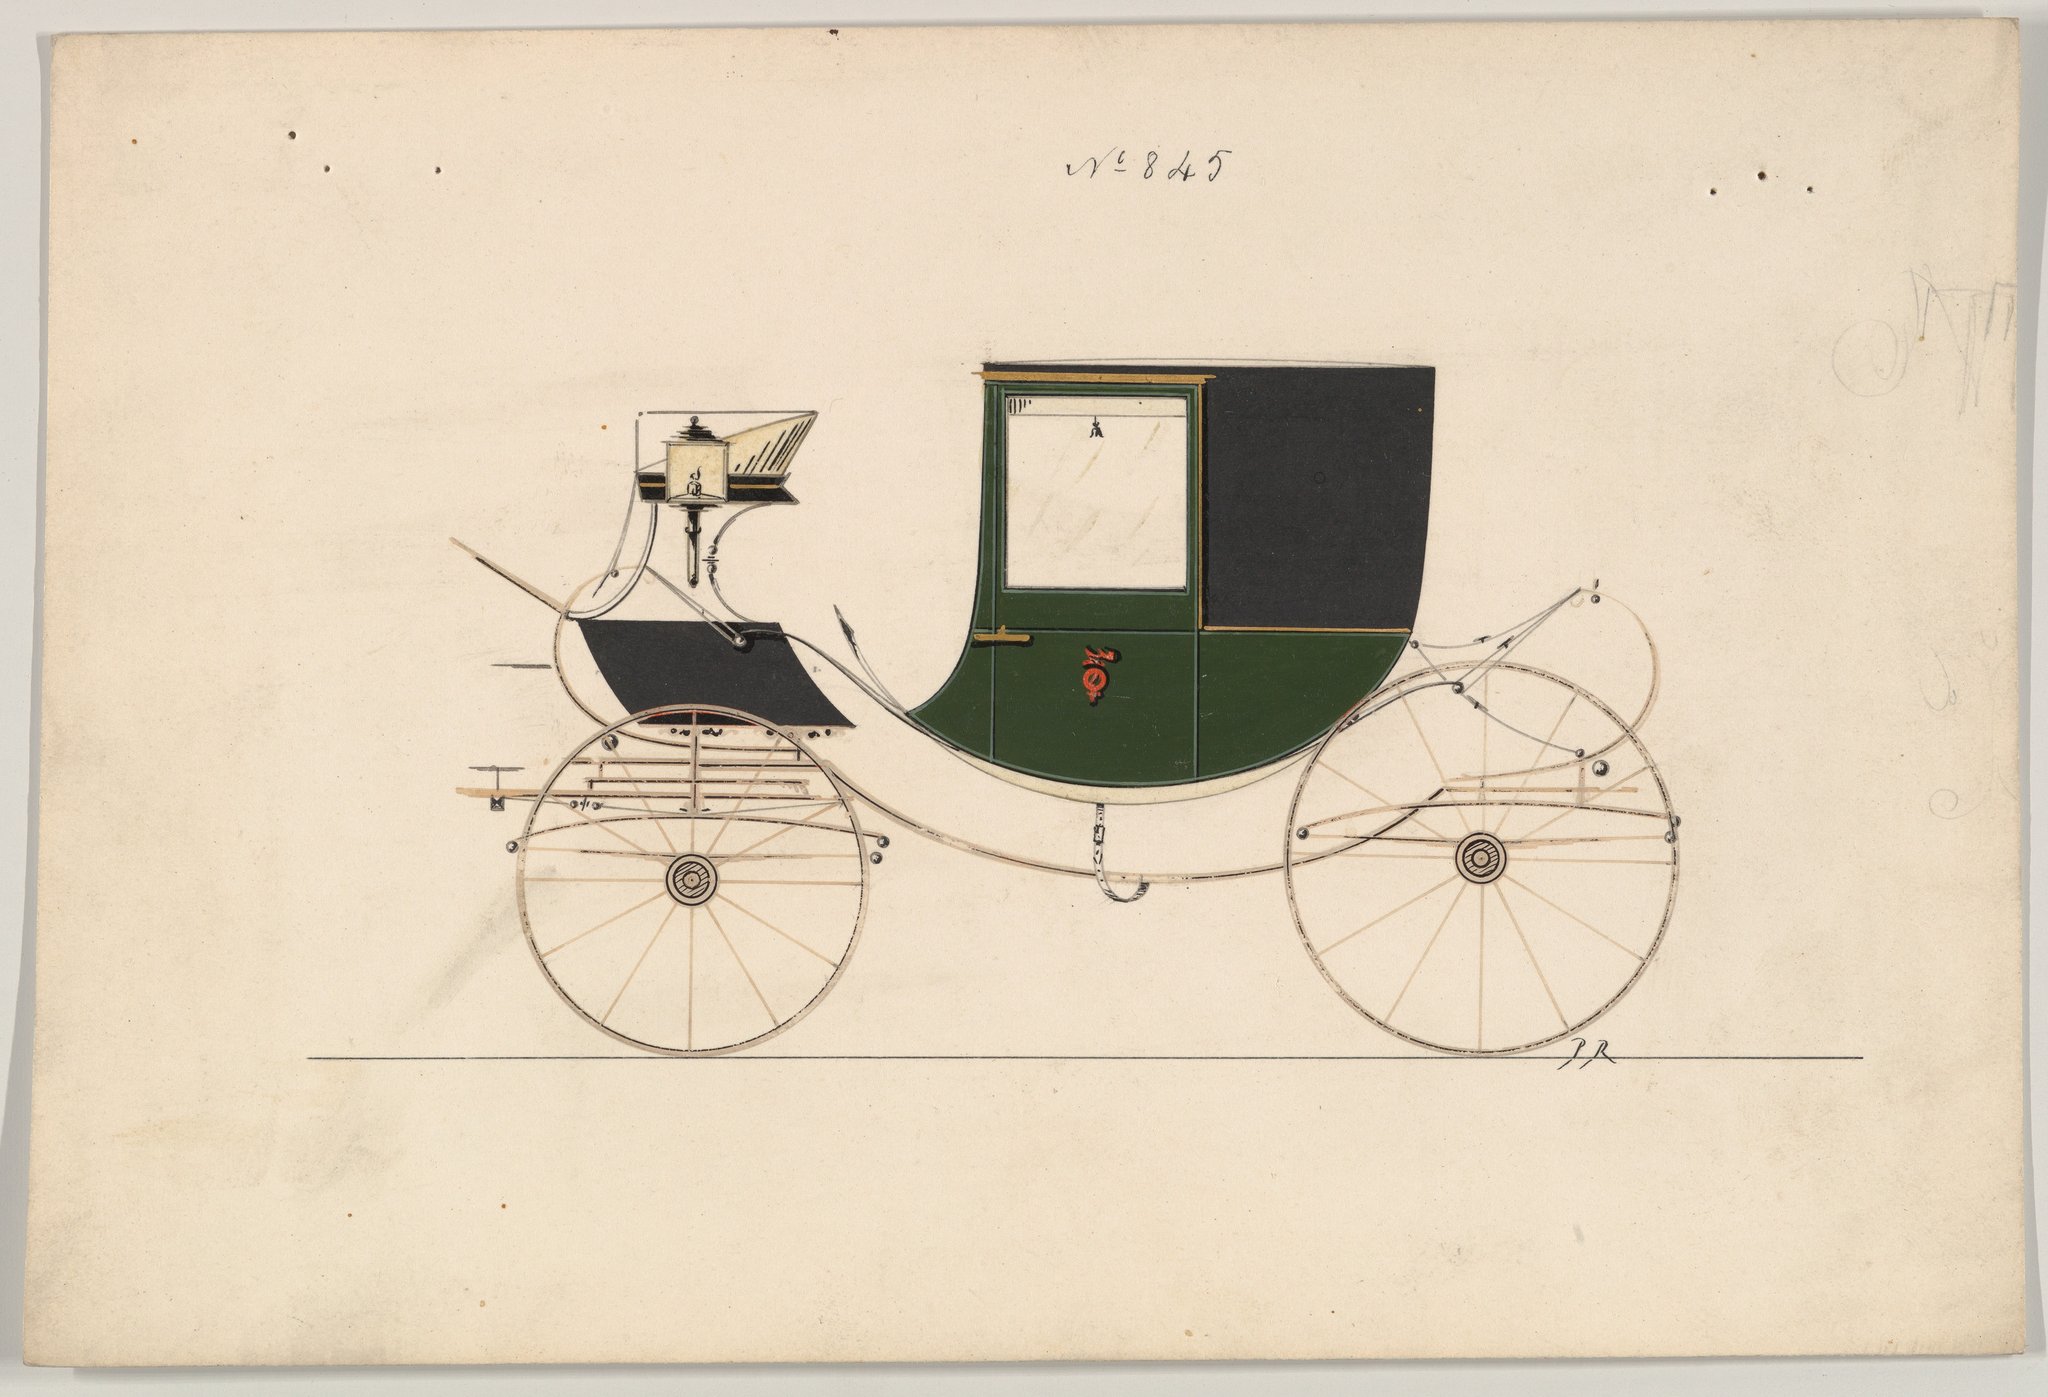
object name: drawing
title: Chariot #845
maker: brewster & co.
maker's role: manufacturer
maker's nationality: american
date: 1850-1870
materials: gouache, gum arabic, ink, watercolor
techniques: pen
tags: carriages